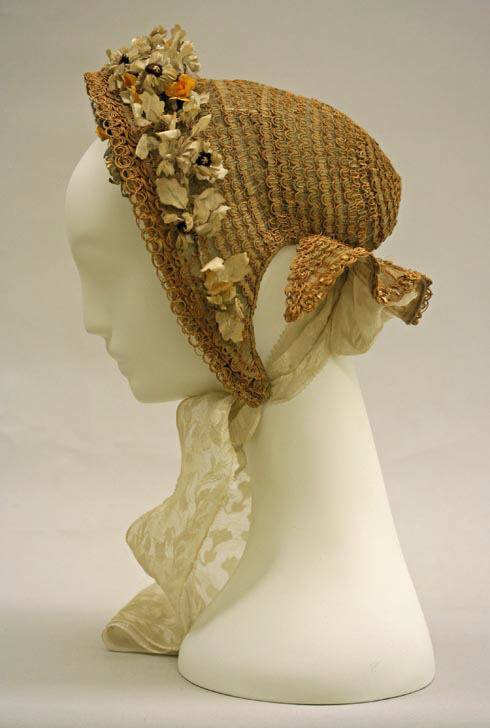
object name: bonnet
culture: american or european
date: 1838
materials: hair, fiber